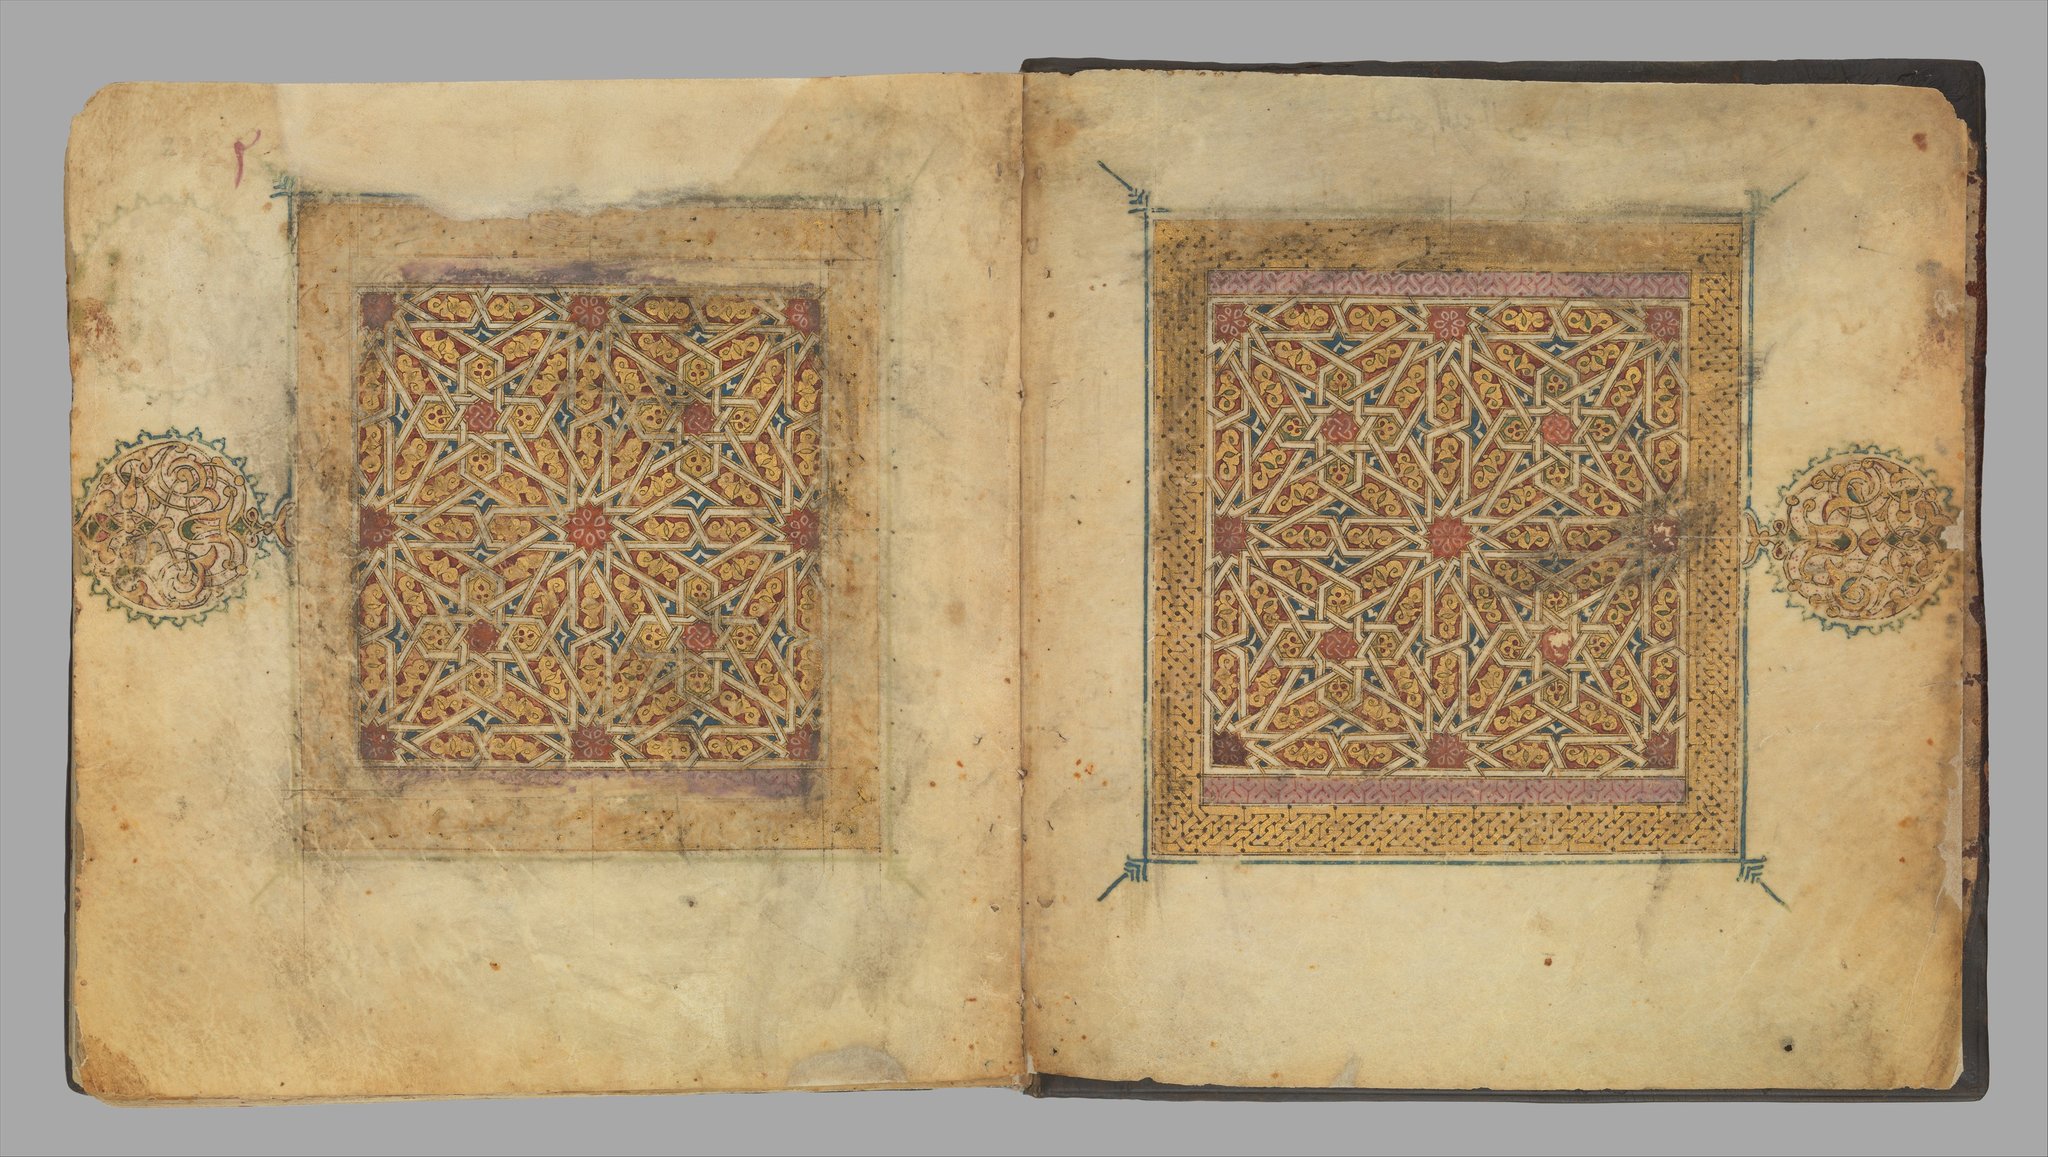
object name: section from a non illustrated manuscript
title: Section from a Qur'an Manuscript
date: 1300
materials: gold, ink, parchment, watercolor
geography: morocco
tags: qur'an